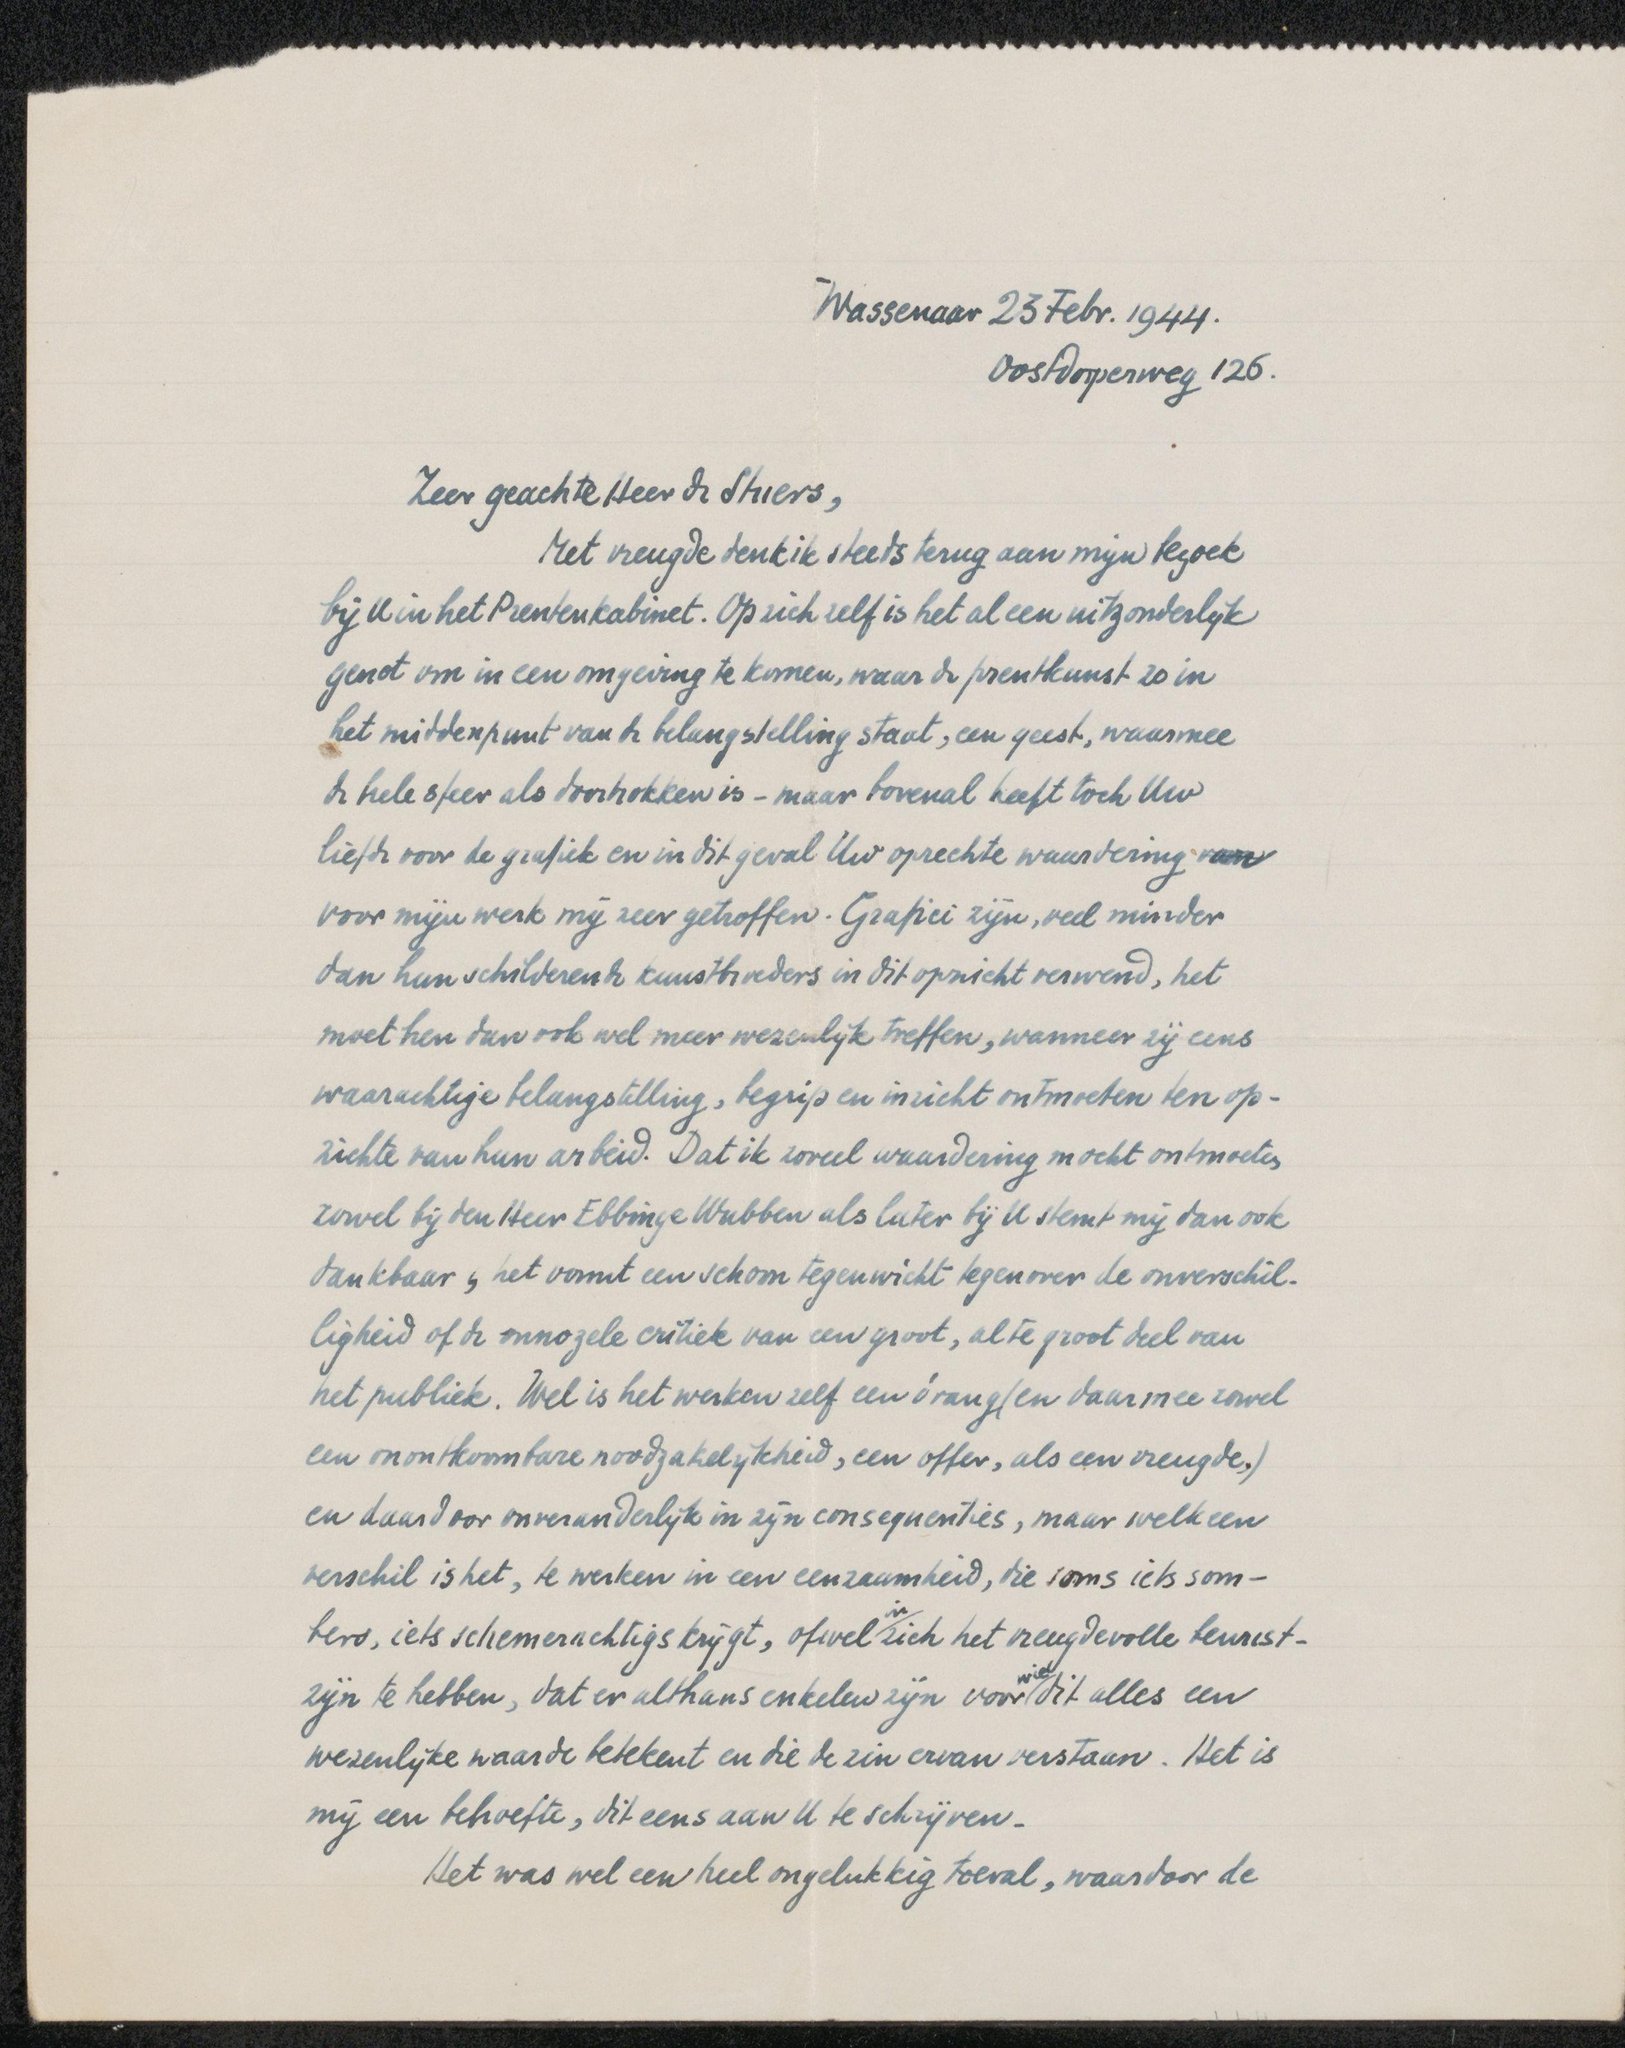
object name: letter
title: Brief aan jonkheer Charles Hubert de Stuers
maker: arend hendriks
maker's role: print maker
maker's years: 1901-1951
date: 1944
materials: ink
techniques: pen, writing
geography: wassenaar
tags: draughtsman, print room, the graphic arts